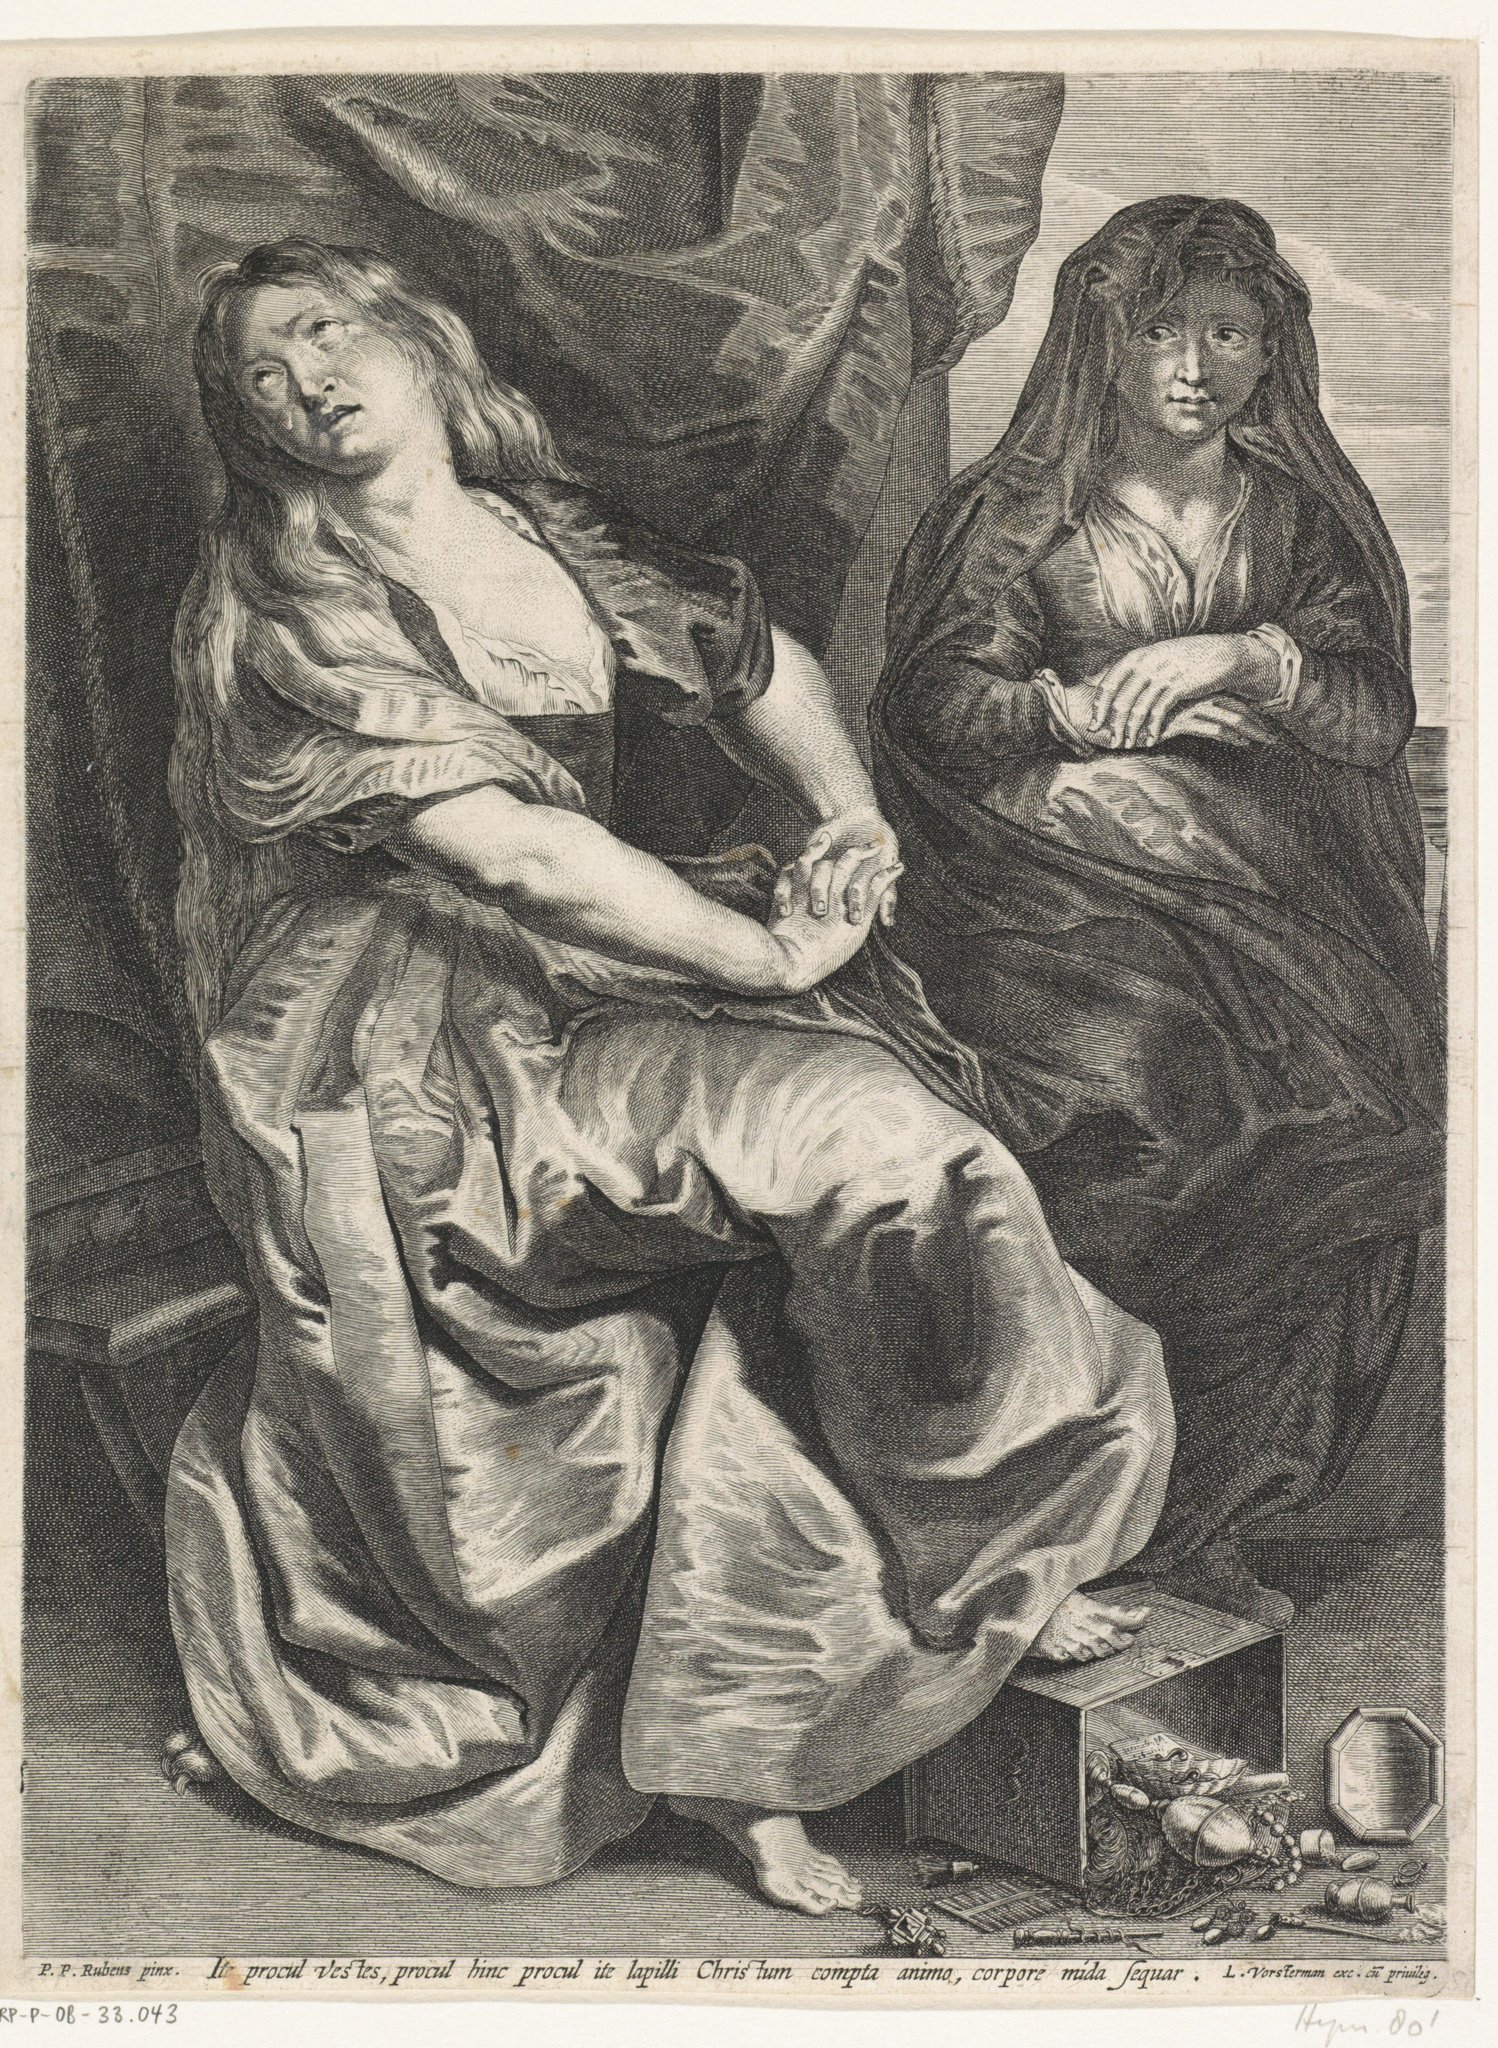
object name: print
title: Maria Magdalena doet afstand van aardse ijdelheden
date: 1619-1675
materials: paper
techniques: engraving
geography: antwerp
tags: st. mary magdalene renounces the vanities of the world, laying aside her jewels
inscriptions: collector's mark: Lugt 240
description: Maria Magdalena vertrapt een kist met haar aardse bezittingen, waaronder een spiegel, parfumflesje, haarspelden en sieraden.